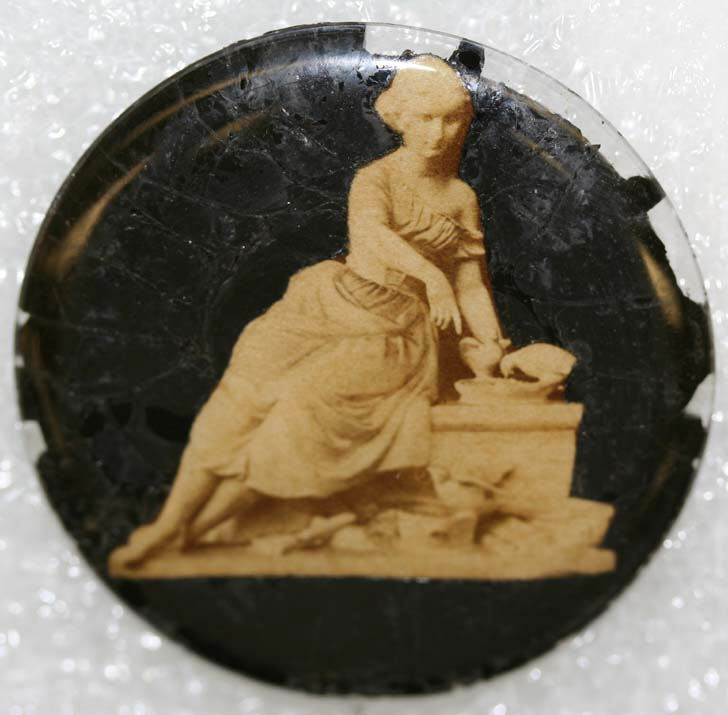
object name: button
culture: european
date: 1880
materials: crystal, glass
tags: women